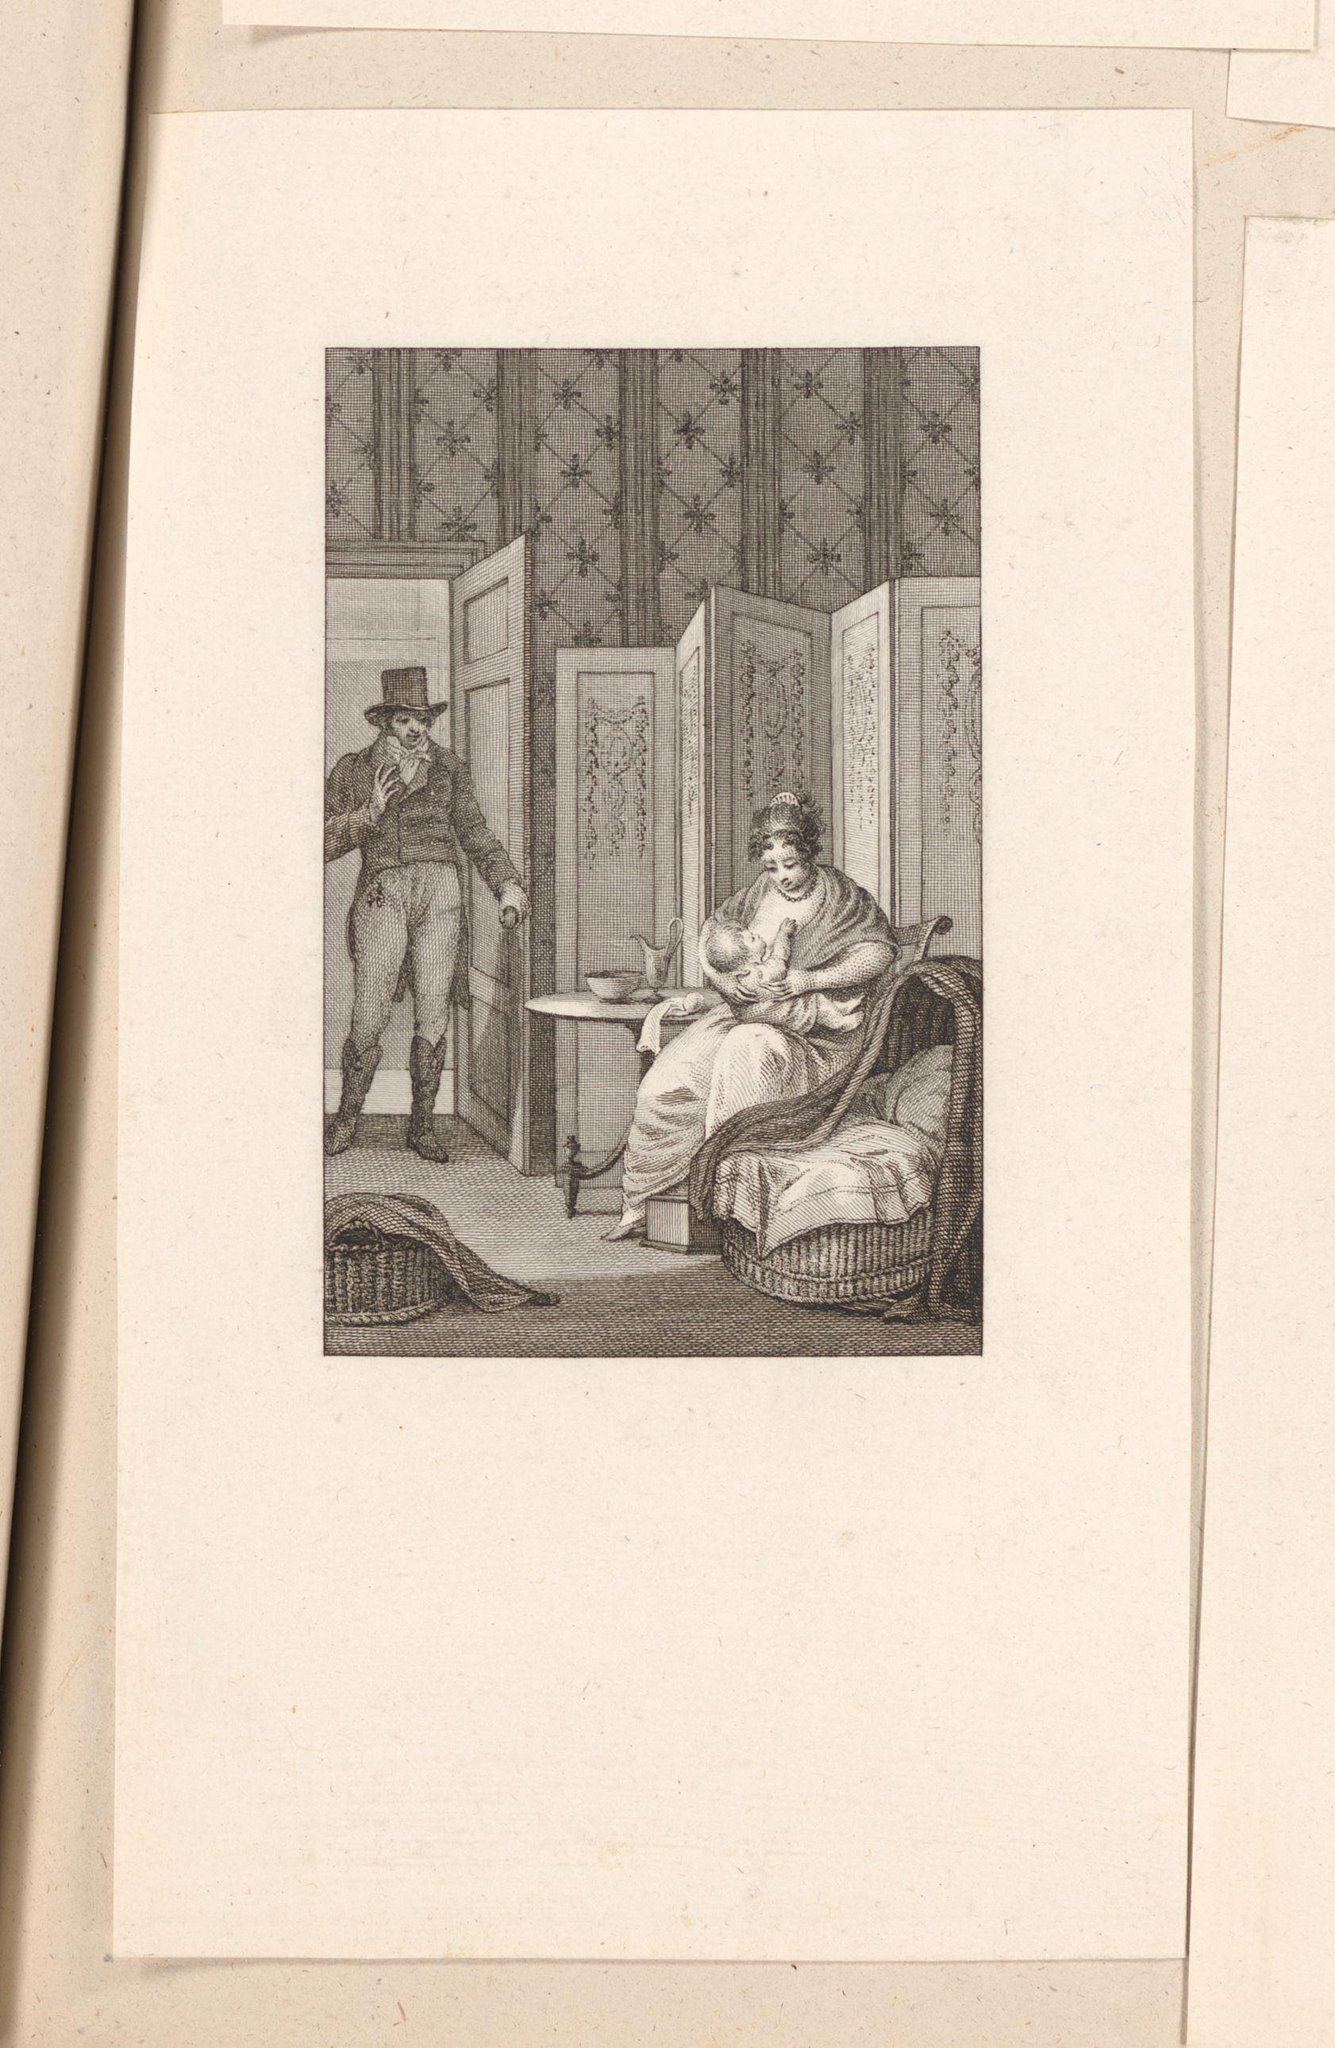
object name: book illustration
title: Moeder met kind voor een kamerscherm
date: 1809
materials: paper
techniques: engraving, etching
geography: haarlem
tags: adult woman, mother and baby or young child, father-love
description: In een vertrek zit een moeder met haar kind op schoot. In de deuropening staat een man. Achter de vrouw een kamerscherm. De prent maakt deel uit van een album.